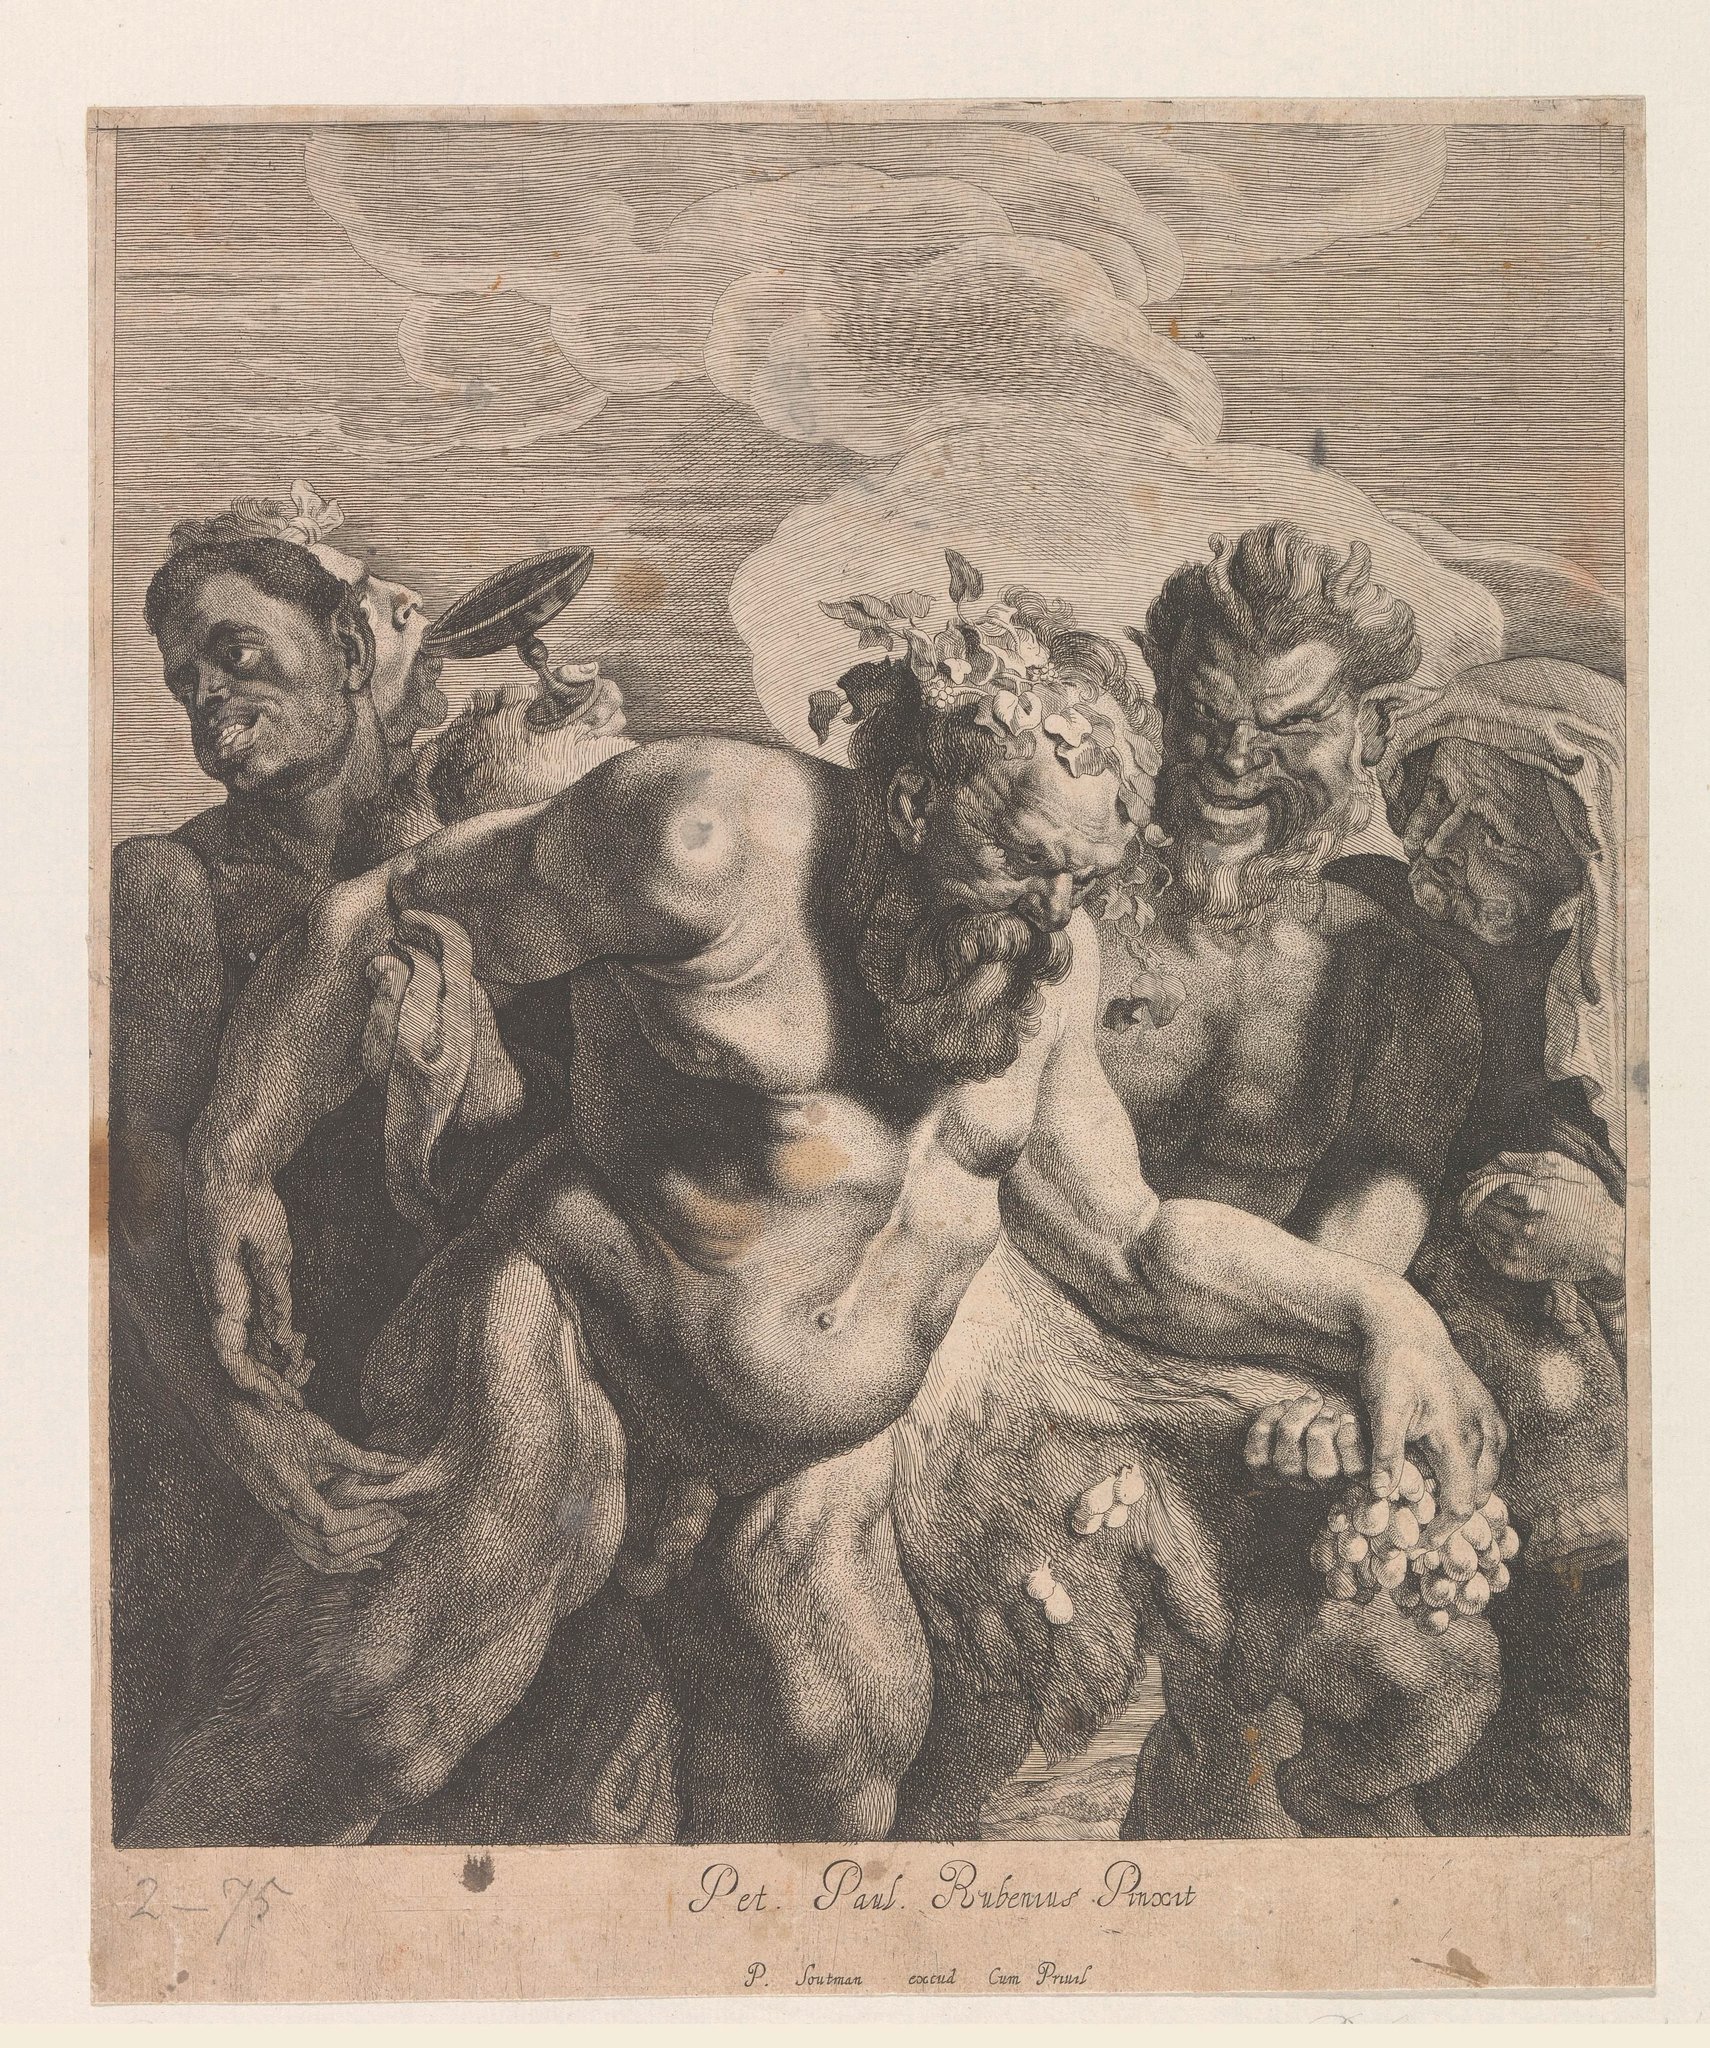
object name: print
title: Dronken Silenus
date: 1644-1650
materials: paper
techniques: engraving, etching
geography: haarlem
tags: africans, (story of) silenus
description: De dronken Silenus wordt ondersteund door saters. Silenus heeft een krans van wingerdbladeren op het hoofd. Losse prent achterin het album. Deze prent maakt deel uit van een album.